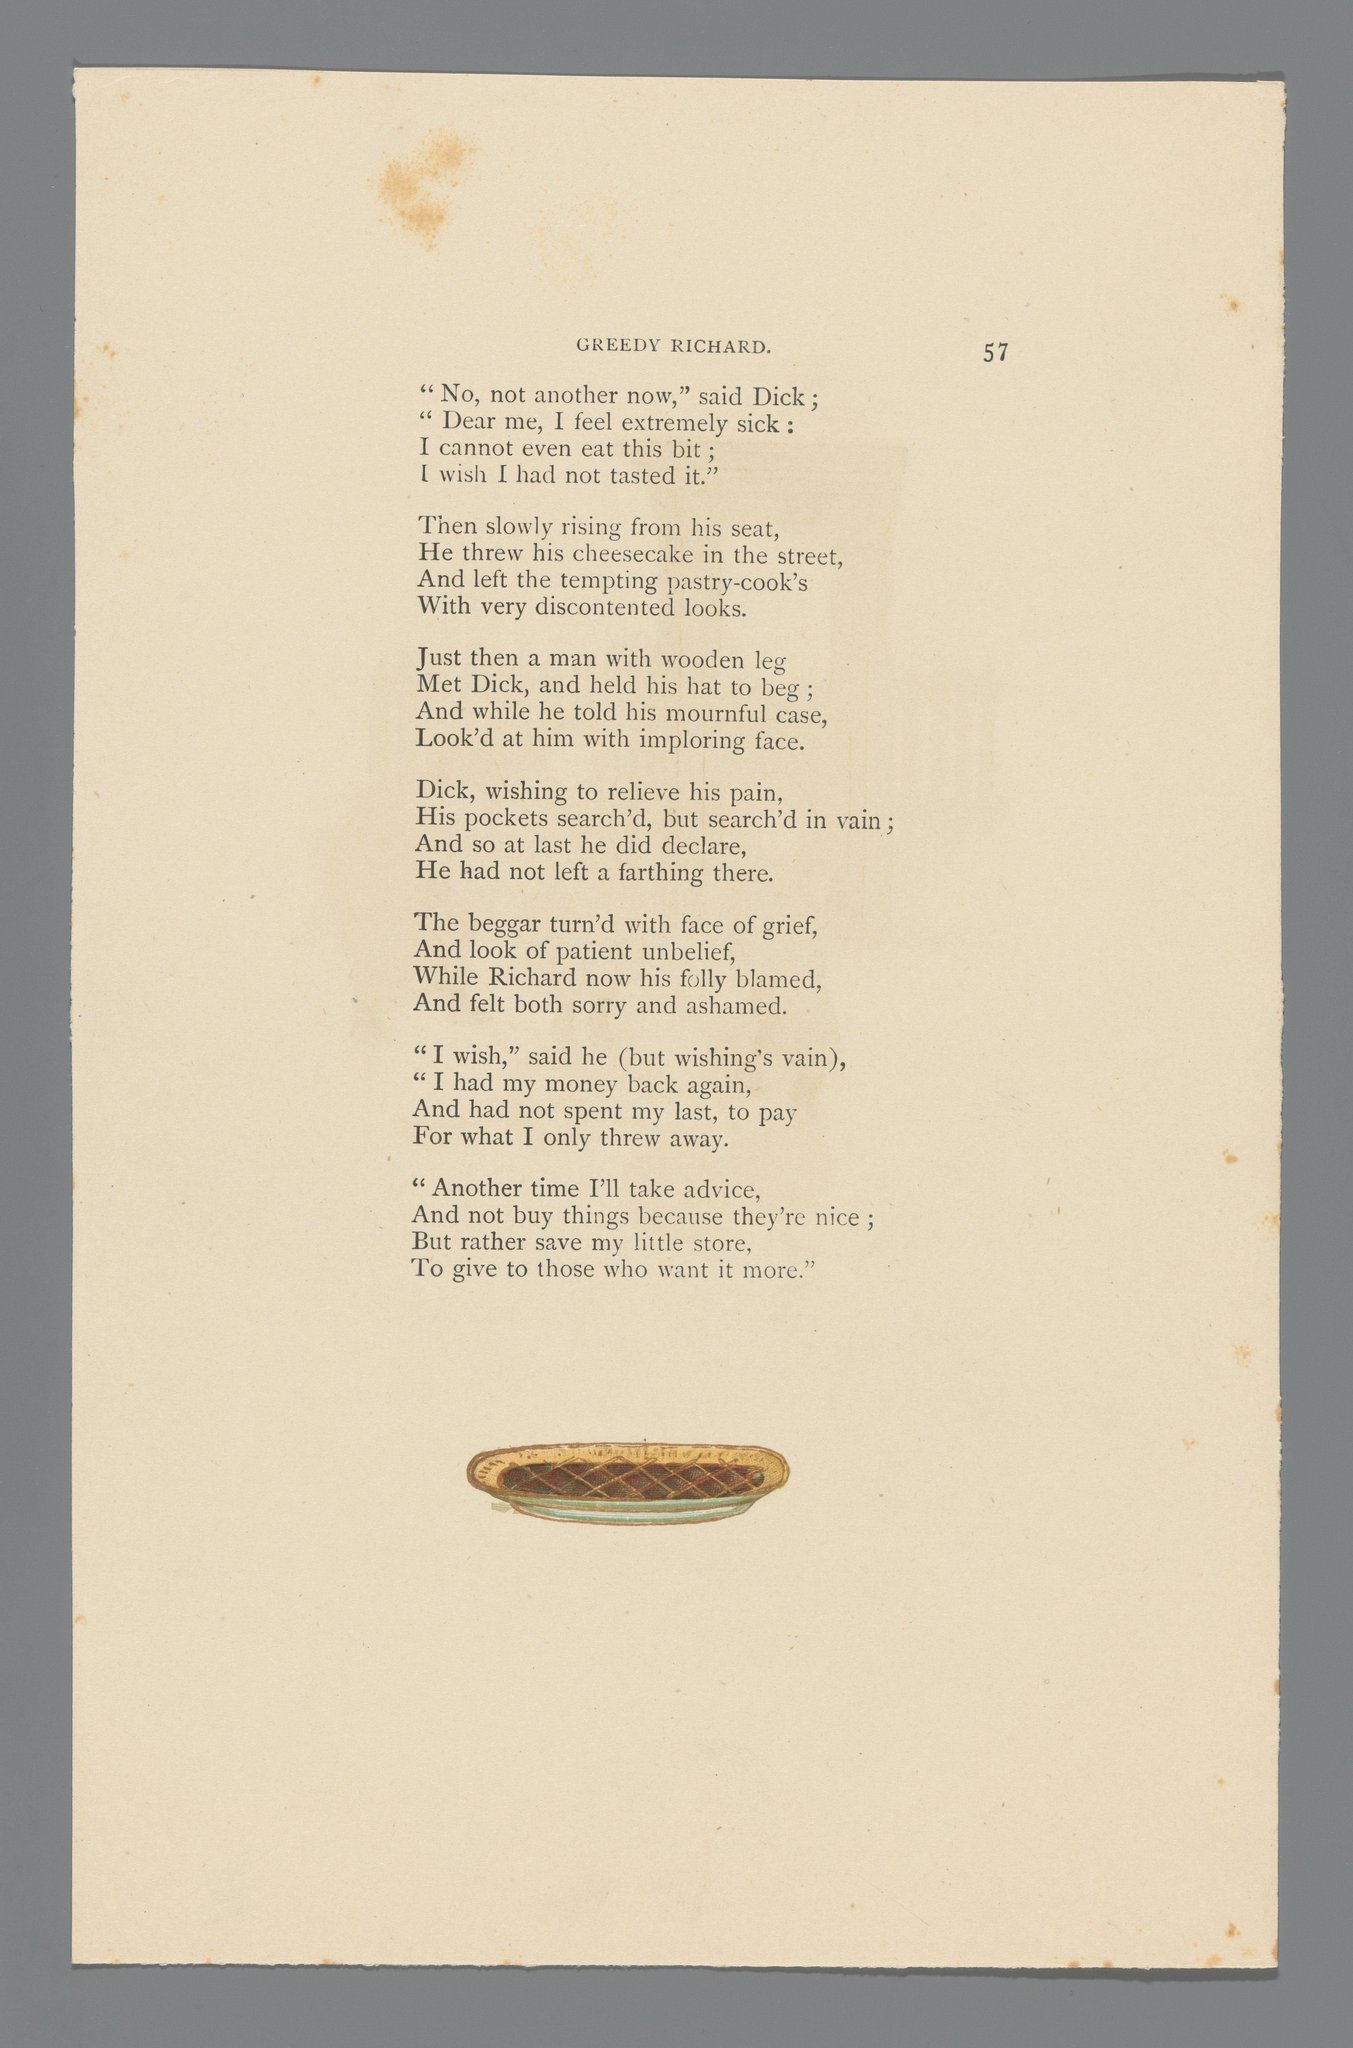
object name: book illustration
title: Schaal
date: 1883-1927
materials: paper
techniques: wood engraving, letterpress printing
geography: london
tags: dish, plate, saucer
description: Prent uit: Jane en Ann Taylor. Little Ann and other poems. Londen: George Routledge & Sons, [1883], p. 57. Of een latere uitgave.